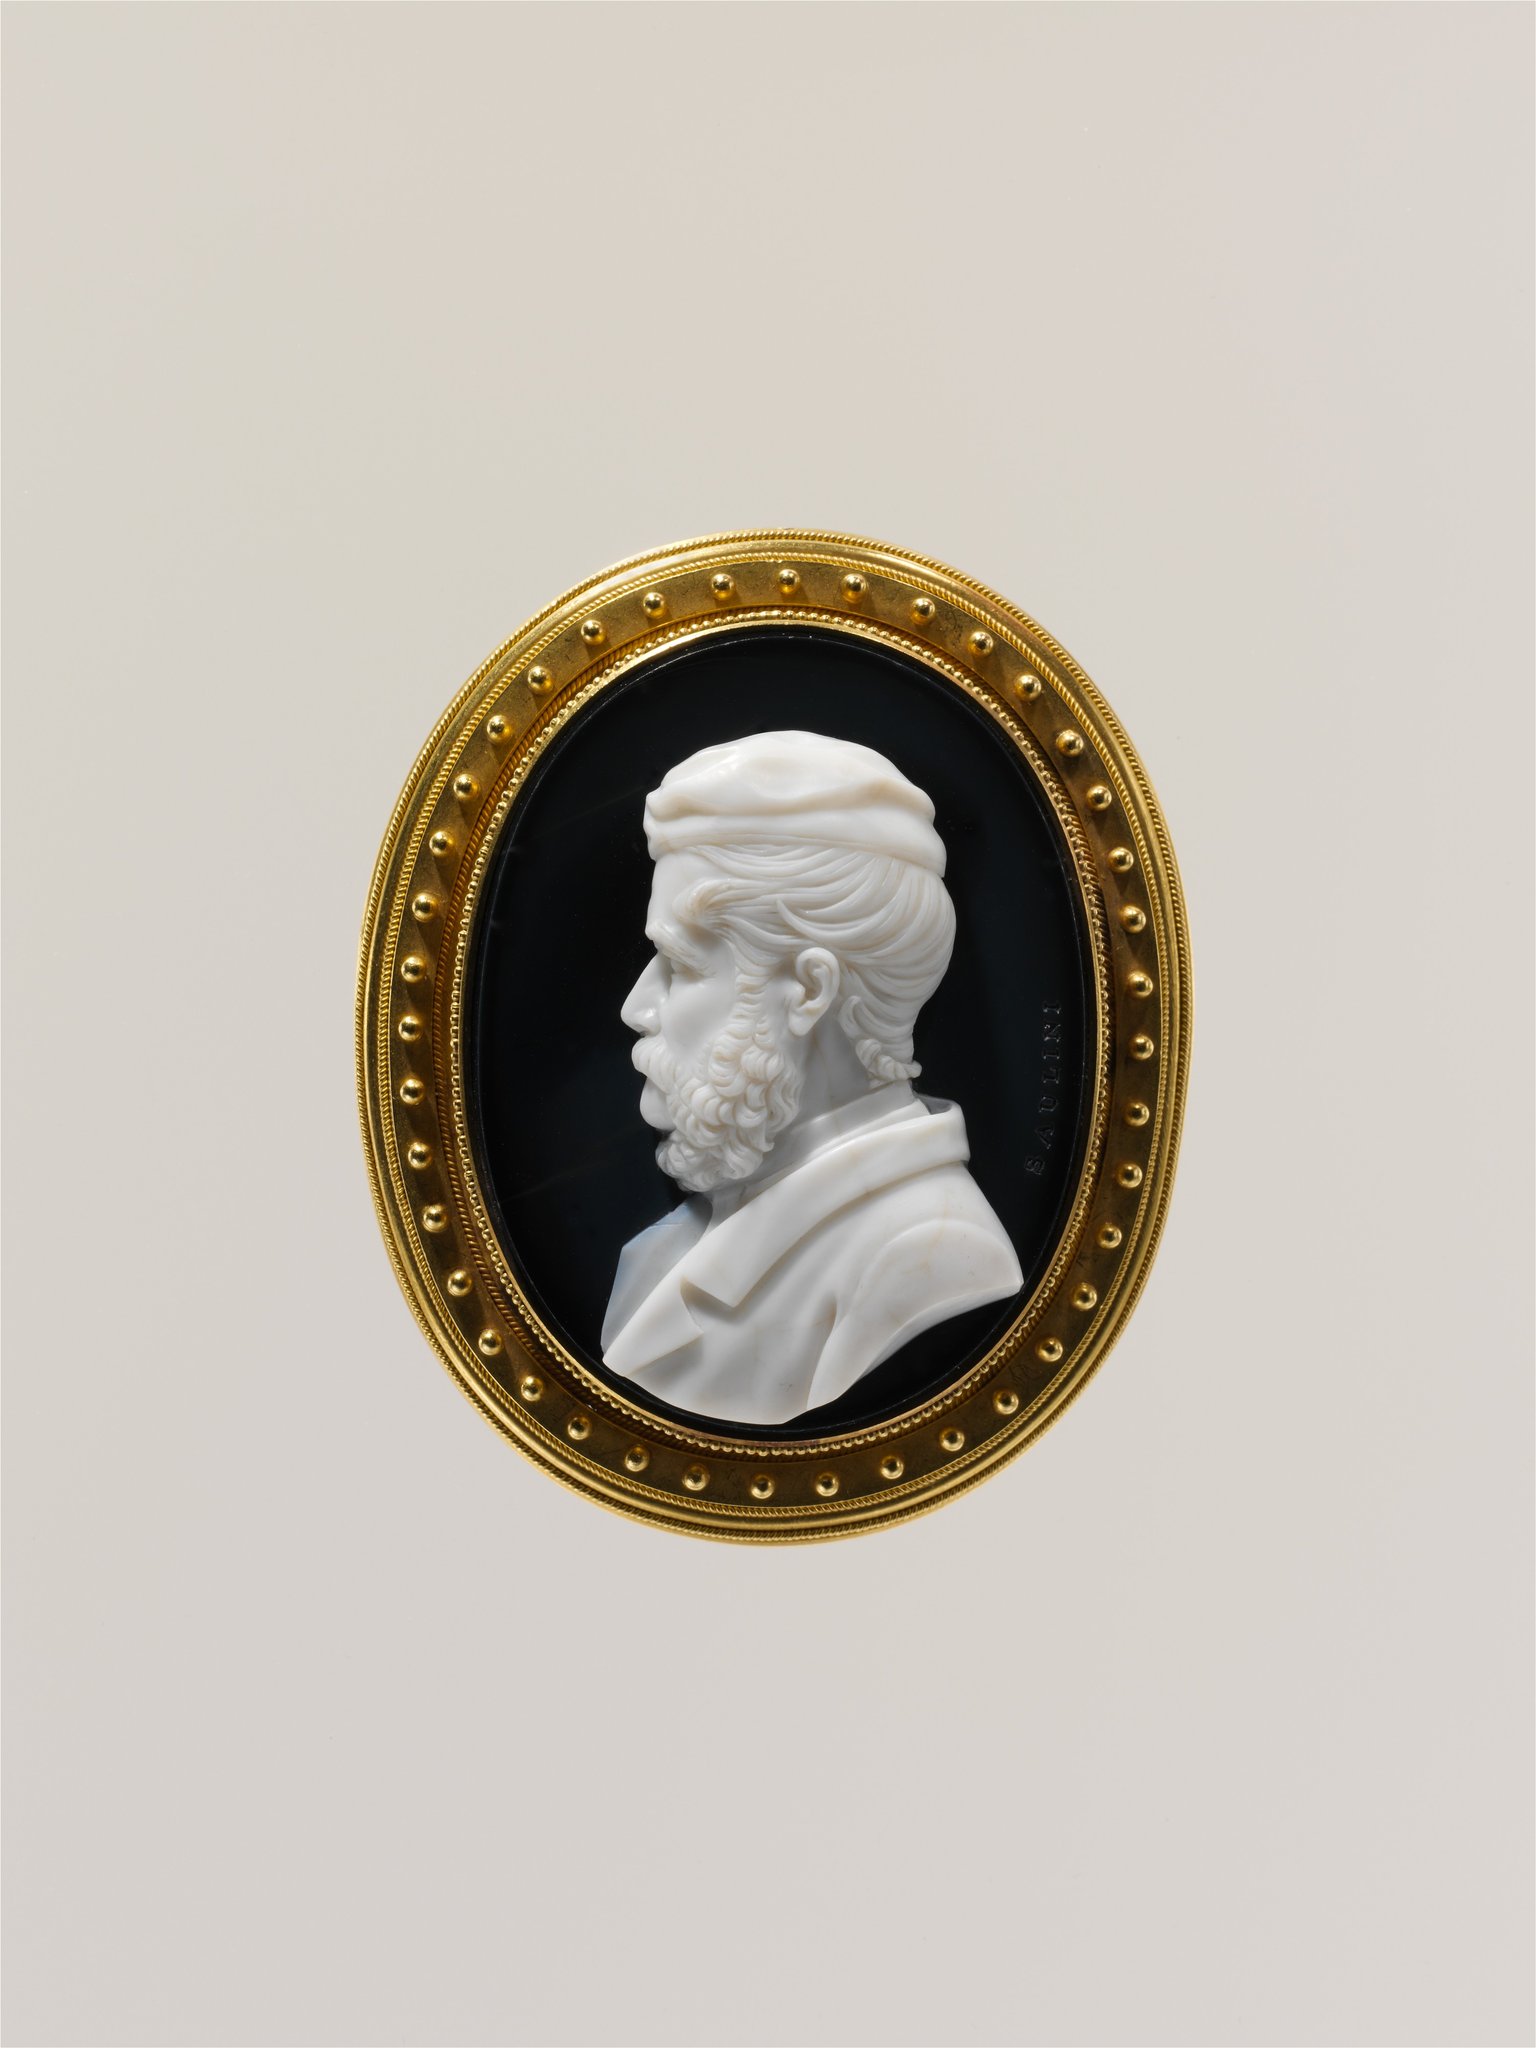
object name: cameo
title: Bust of a bearded man in a cap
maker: luigi saulini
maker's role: artist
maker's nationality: italian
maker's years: 1819-1883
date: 1834-1866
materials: gold, onyx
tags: men,profiles